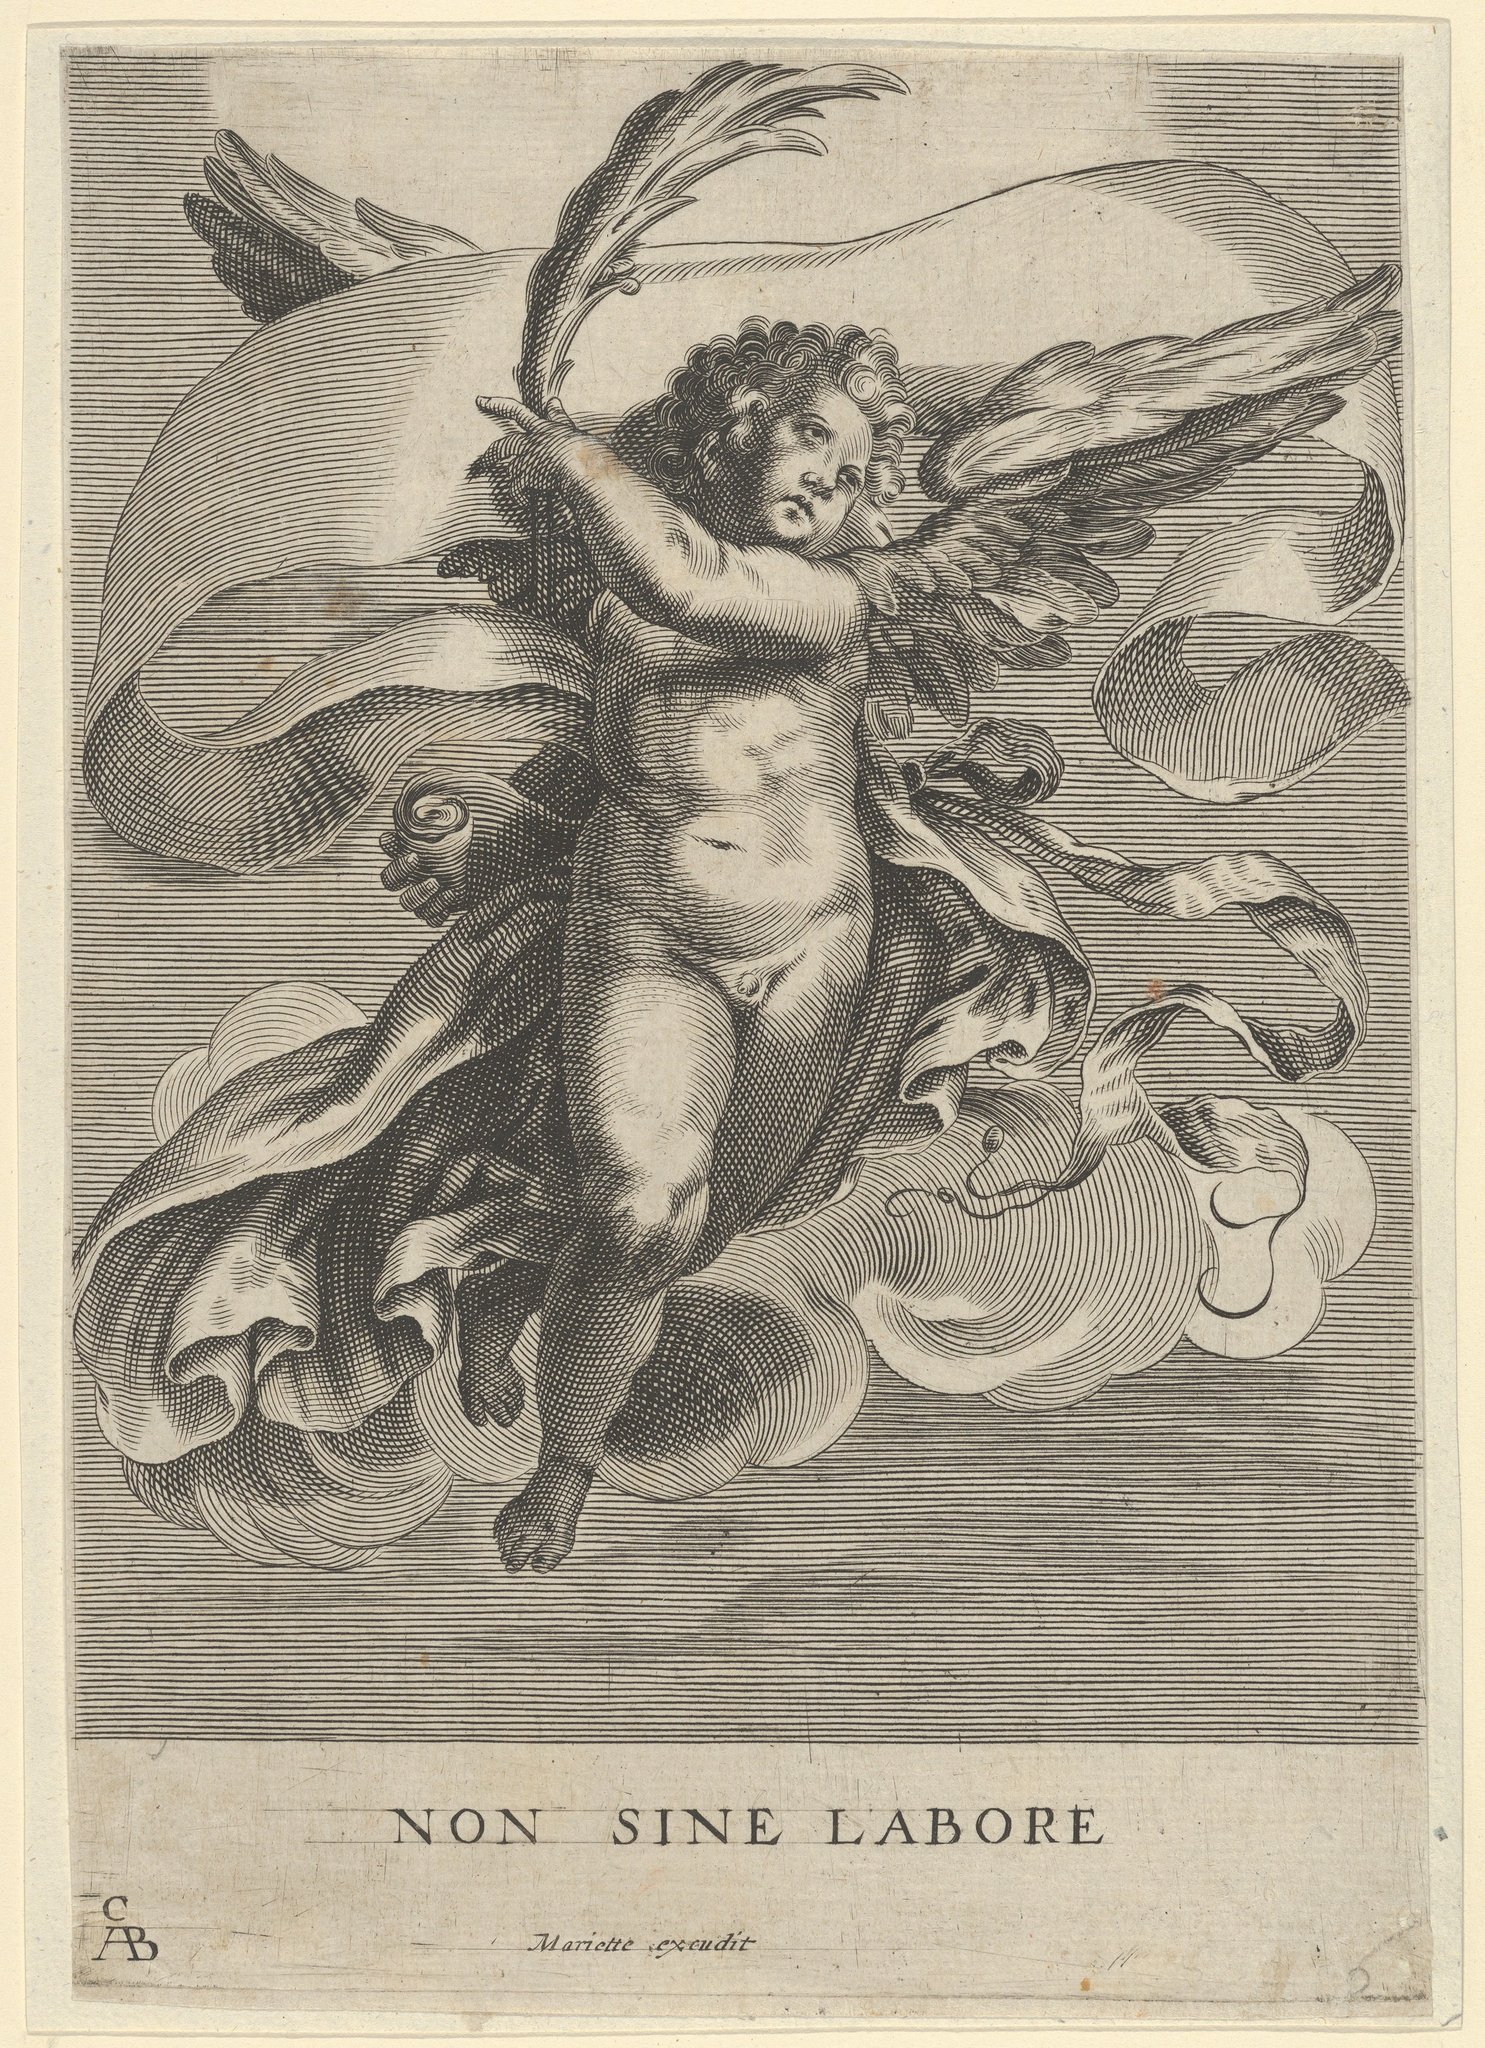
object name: print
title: Winged genius holding a olive branch and a banderole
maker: cherubino alberti (zaccaria mattia)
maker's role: artist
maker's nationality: italian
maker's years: 1553-1615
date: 1601-1700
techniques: engraving